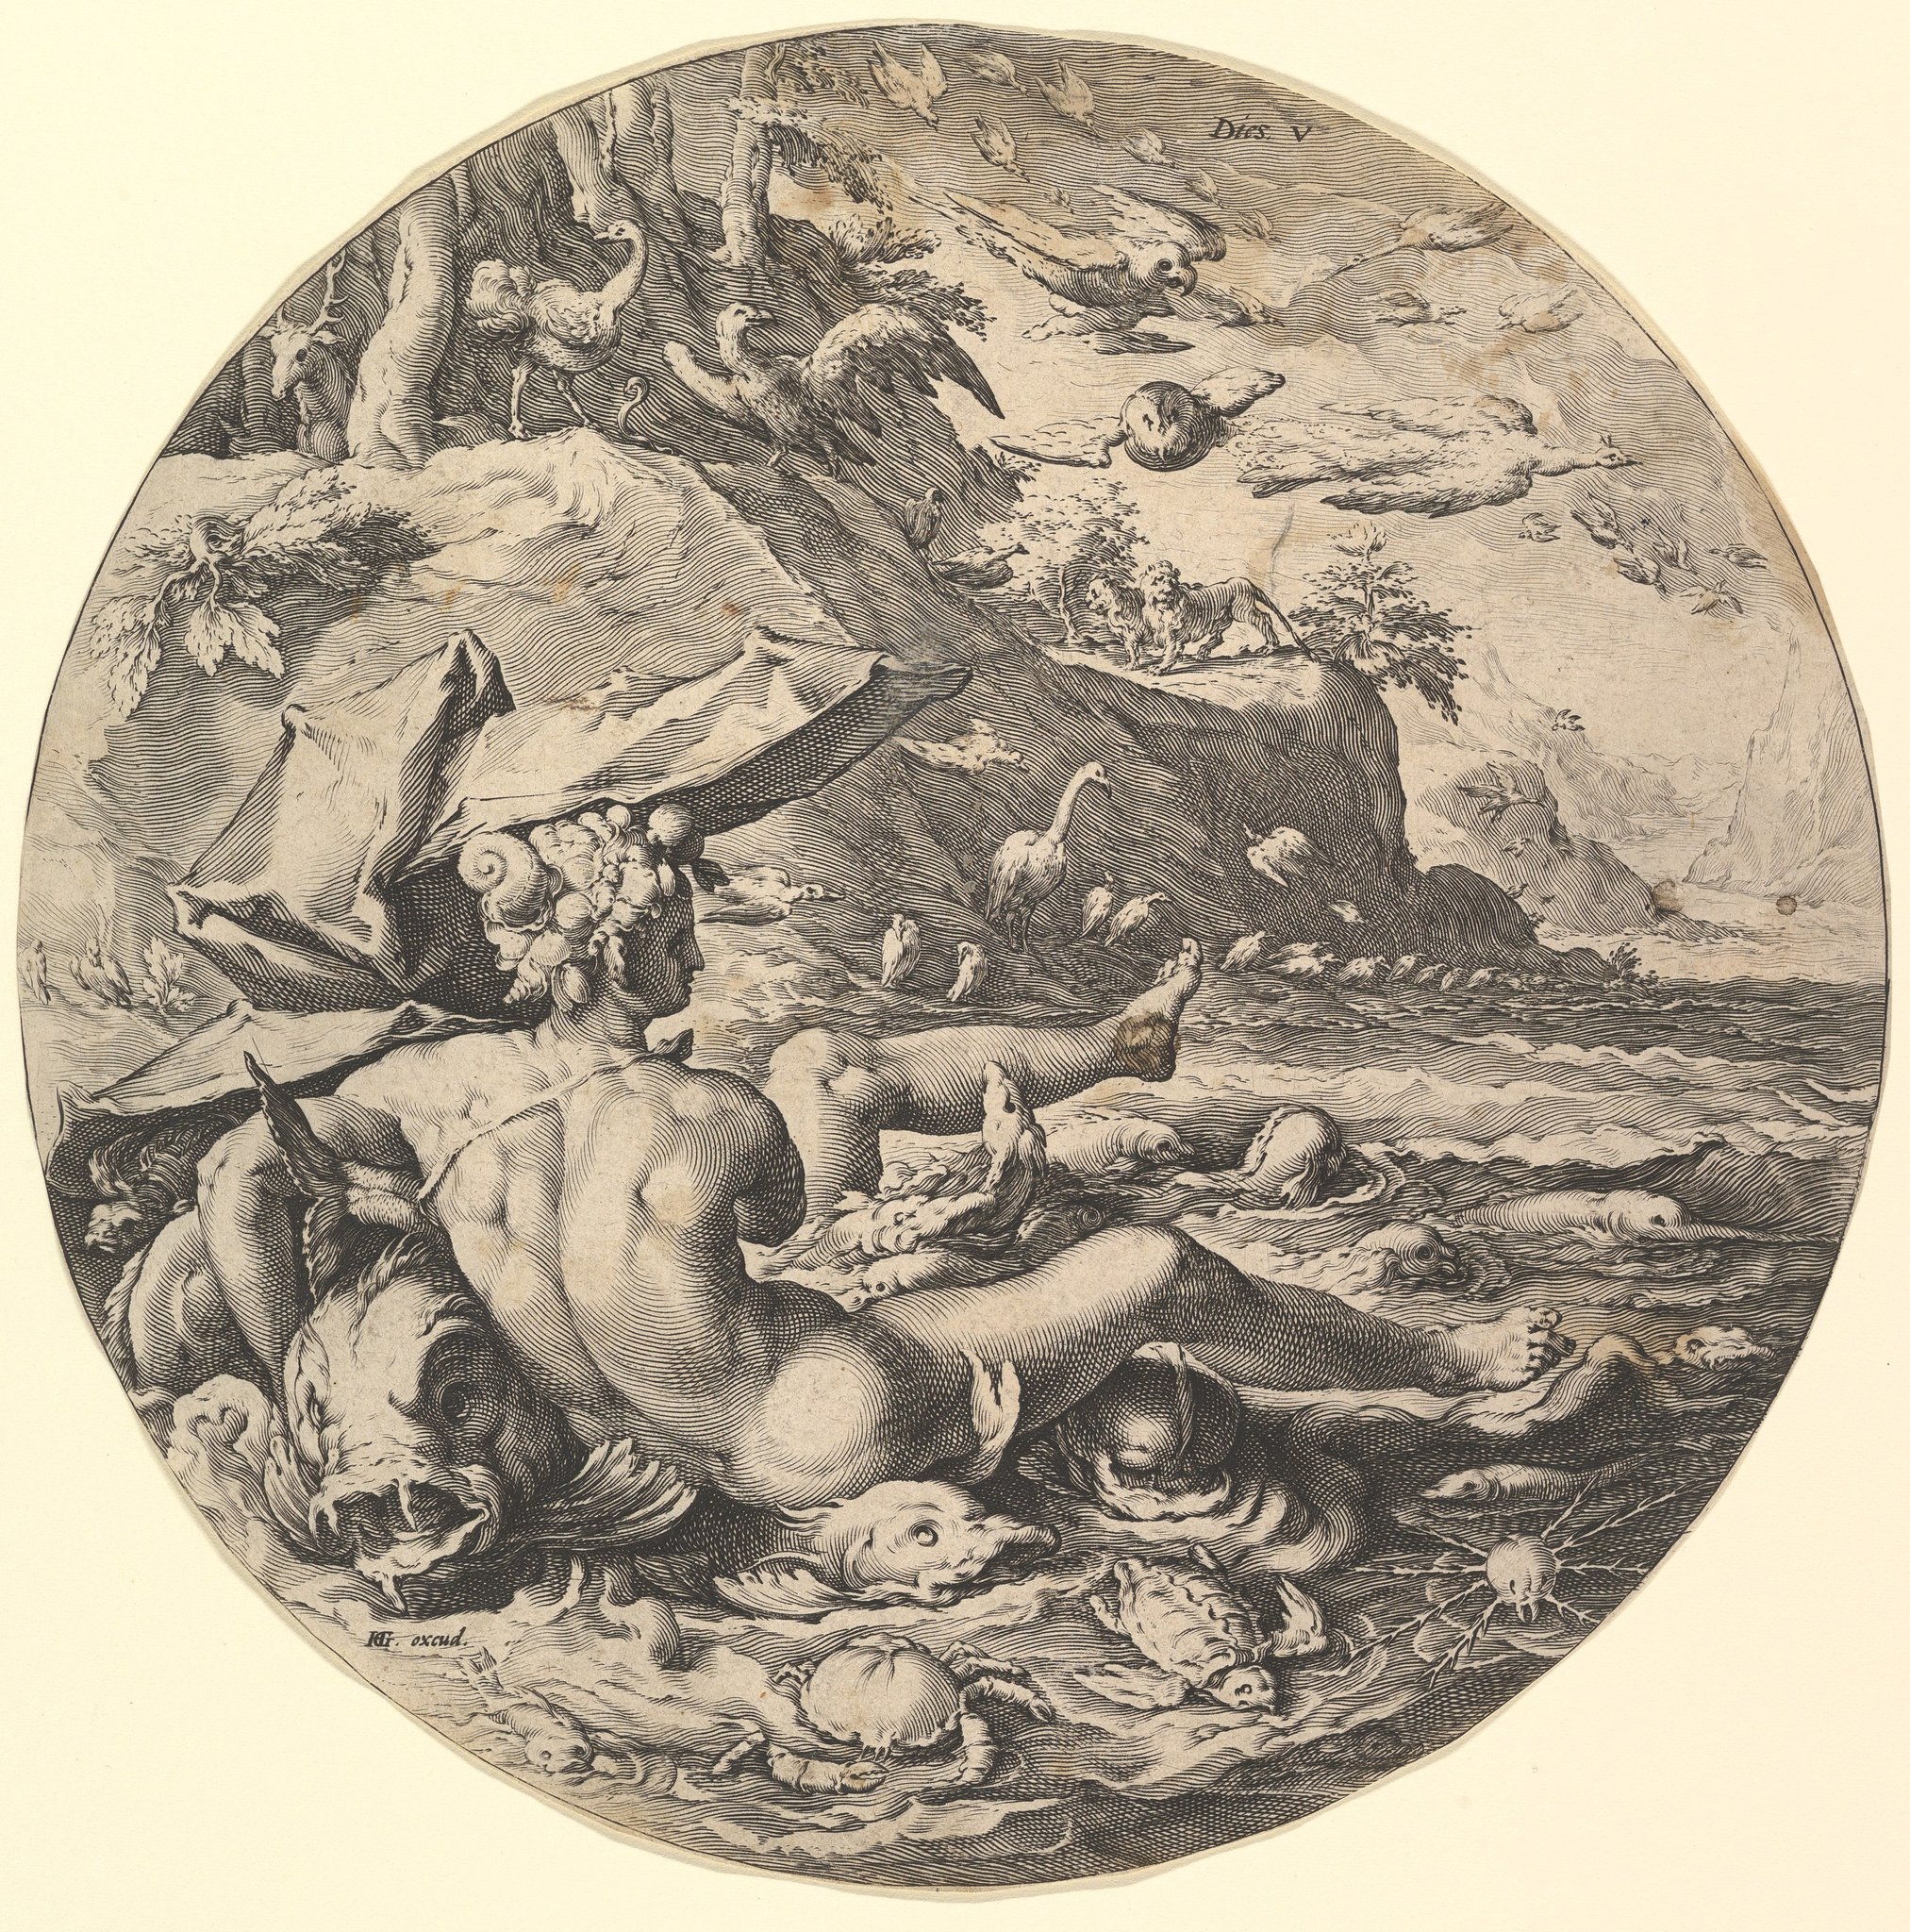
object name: print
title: The Fifth Day (Dies V): The Creation of the Kingdom of Animals, from "The Creation of the World"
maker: jan muller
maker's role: artist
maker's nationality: netherlandish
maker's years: 1571-1628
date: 1589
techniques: engraving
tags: human figures,birds,fish,insects